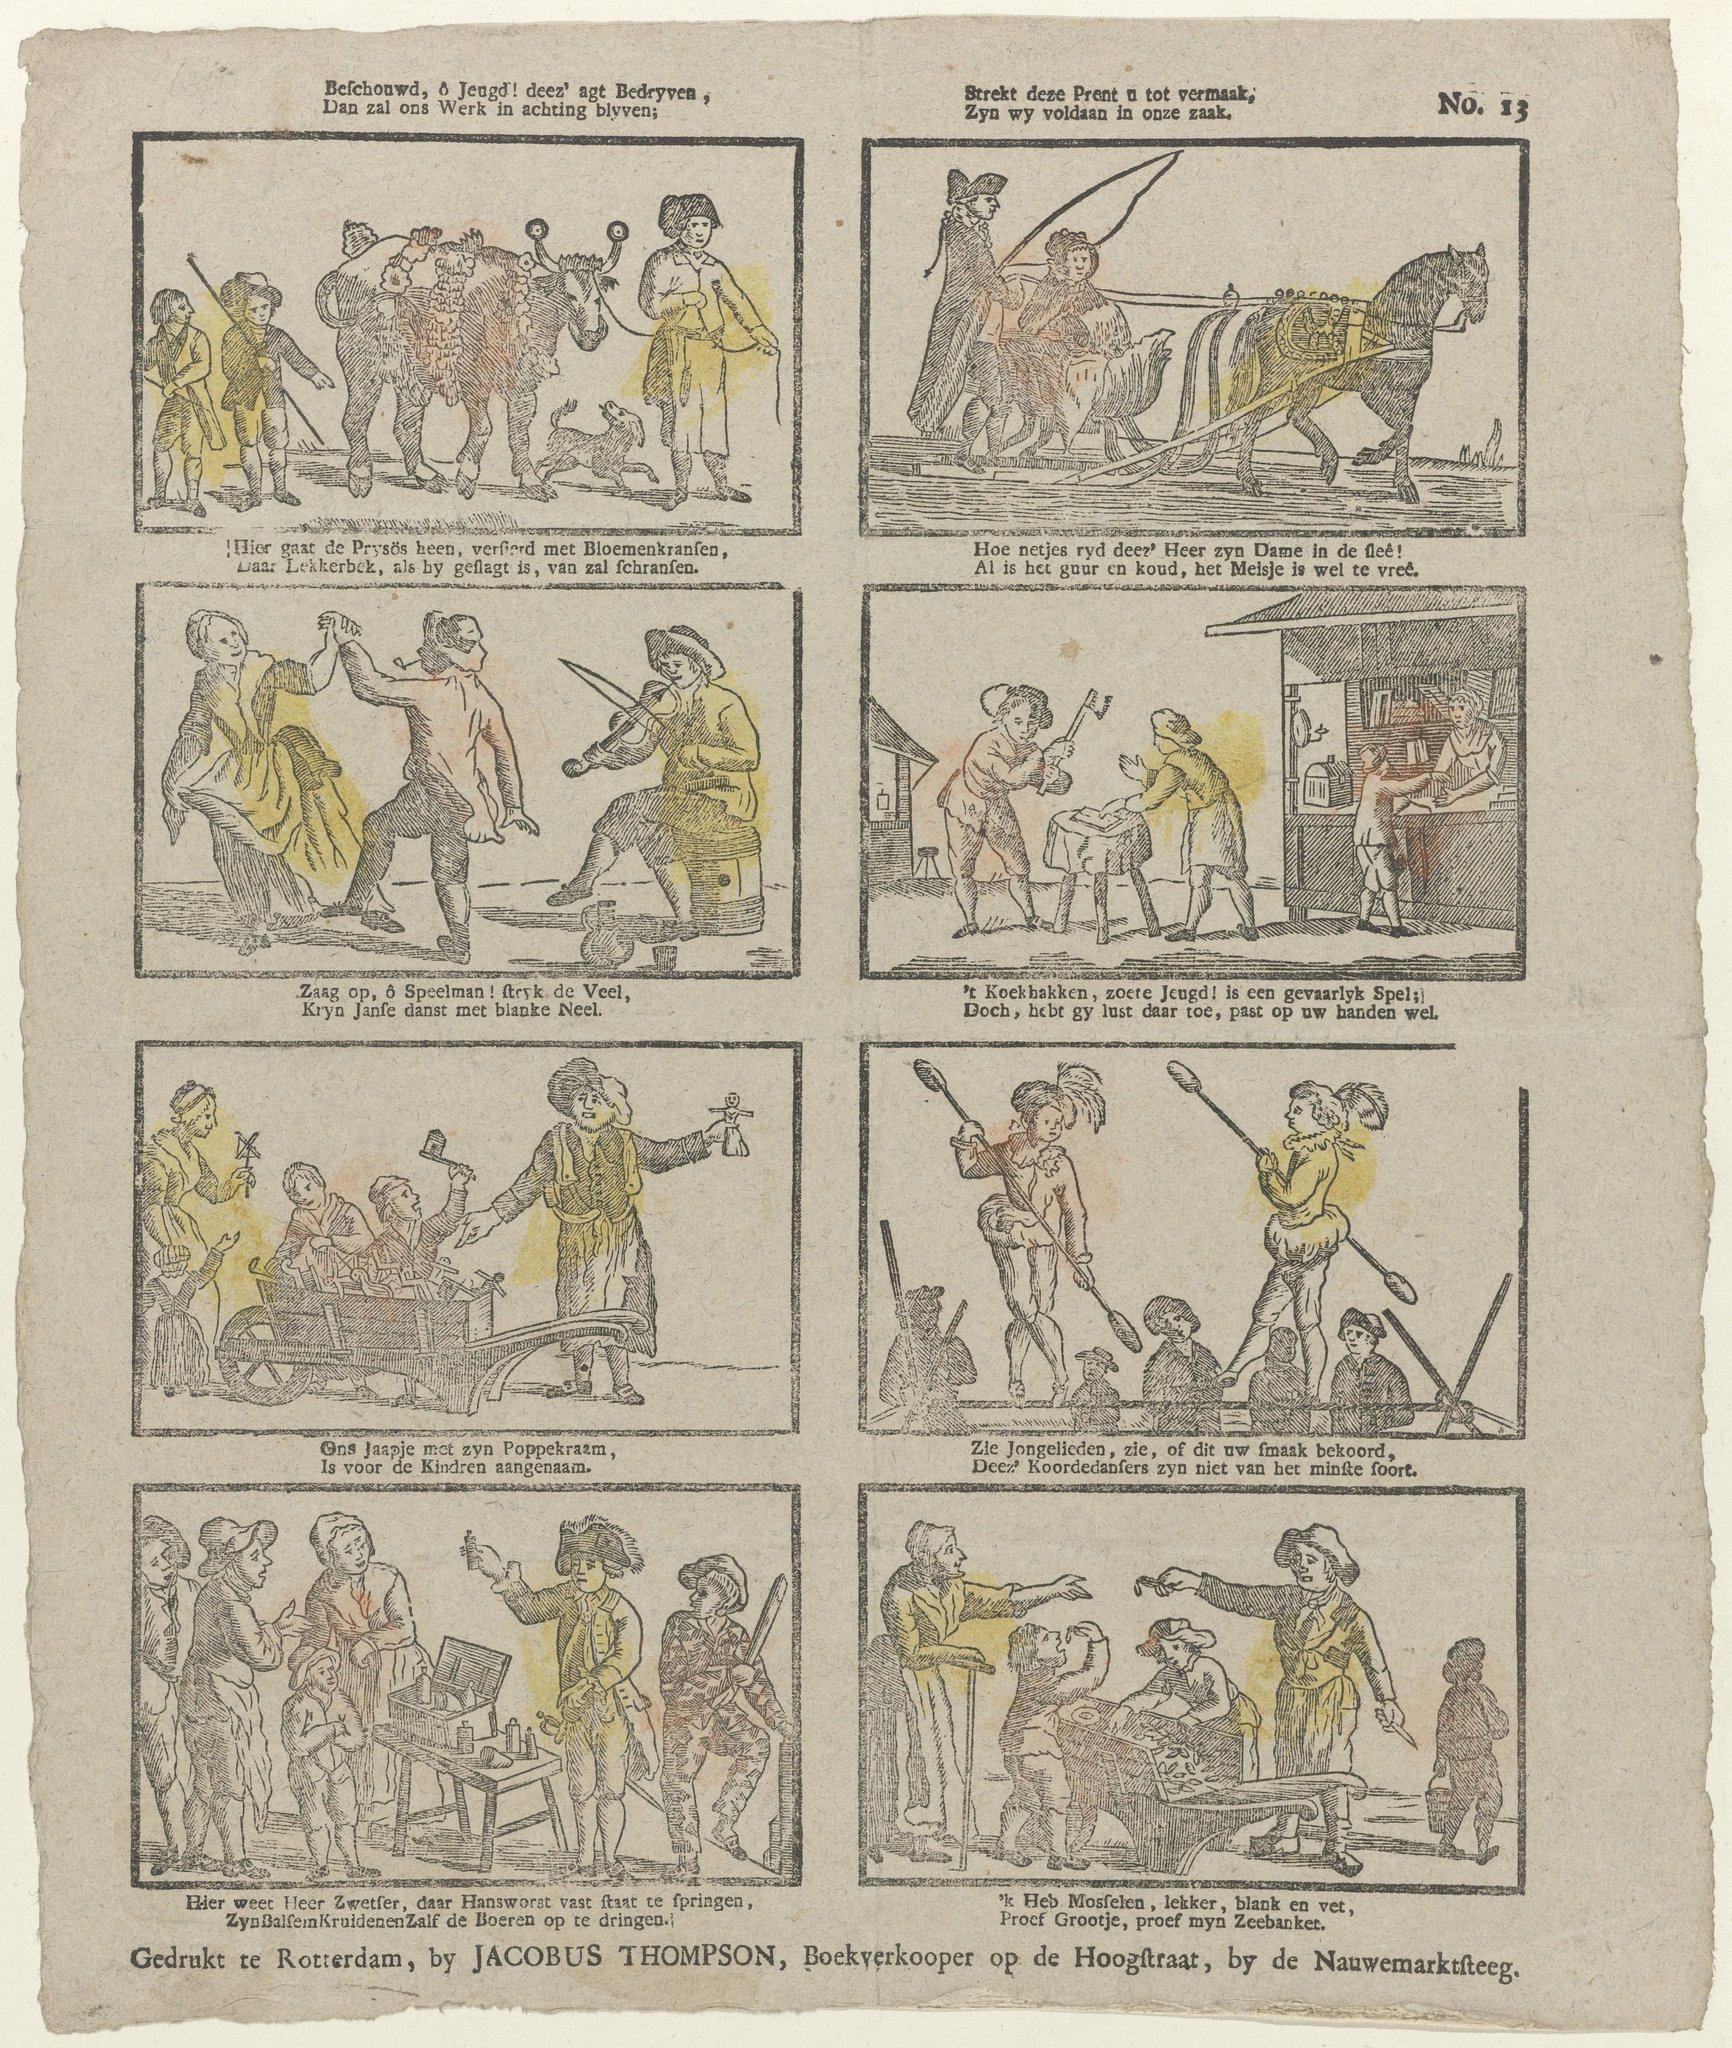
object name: popular print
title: Beschouwd, ô jeugd! deez' agt bedryven, / Dan zal ons werk in achting blyven; / Strekt deze prent u tot vermaak, / Zyn wy voldaan in onze zaak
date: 1791-1812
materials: paper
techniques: colour, letterpress printing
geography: rotterdam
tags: children's games and plays, dancing, street-trader, merchant, salesman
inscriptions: collector's mark: Lugt 2760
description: Blad met 8 voorstellingen van verschillende bezigheden, waaronder dansen, koekhakken en koorddansen. Onder elke voorstelling een tweeregelig vers. Genummerd rechtsboven: No. 13.